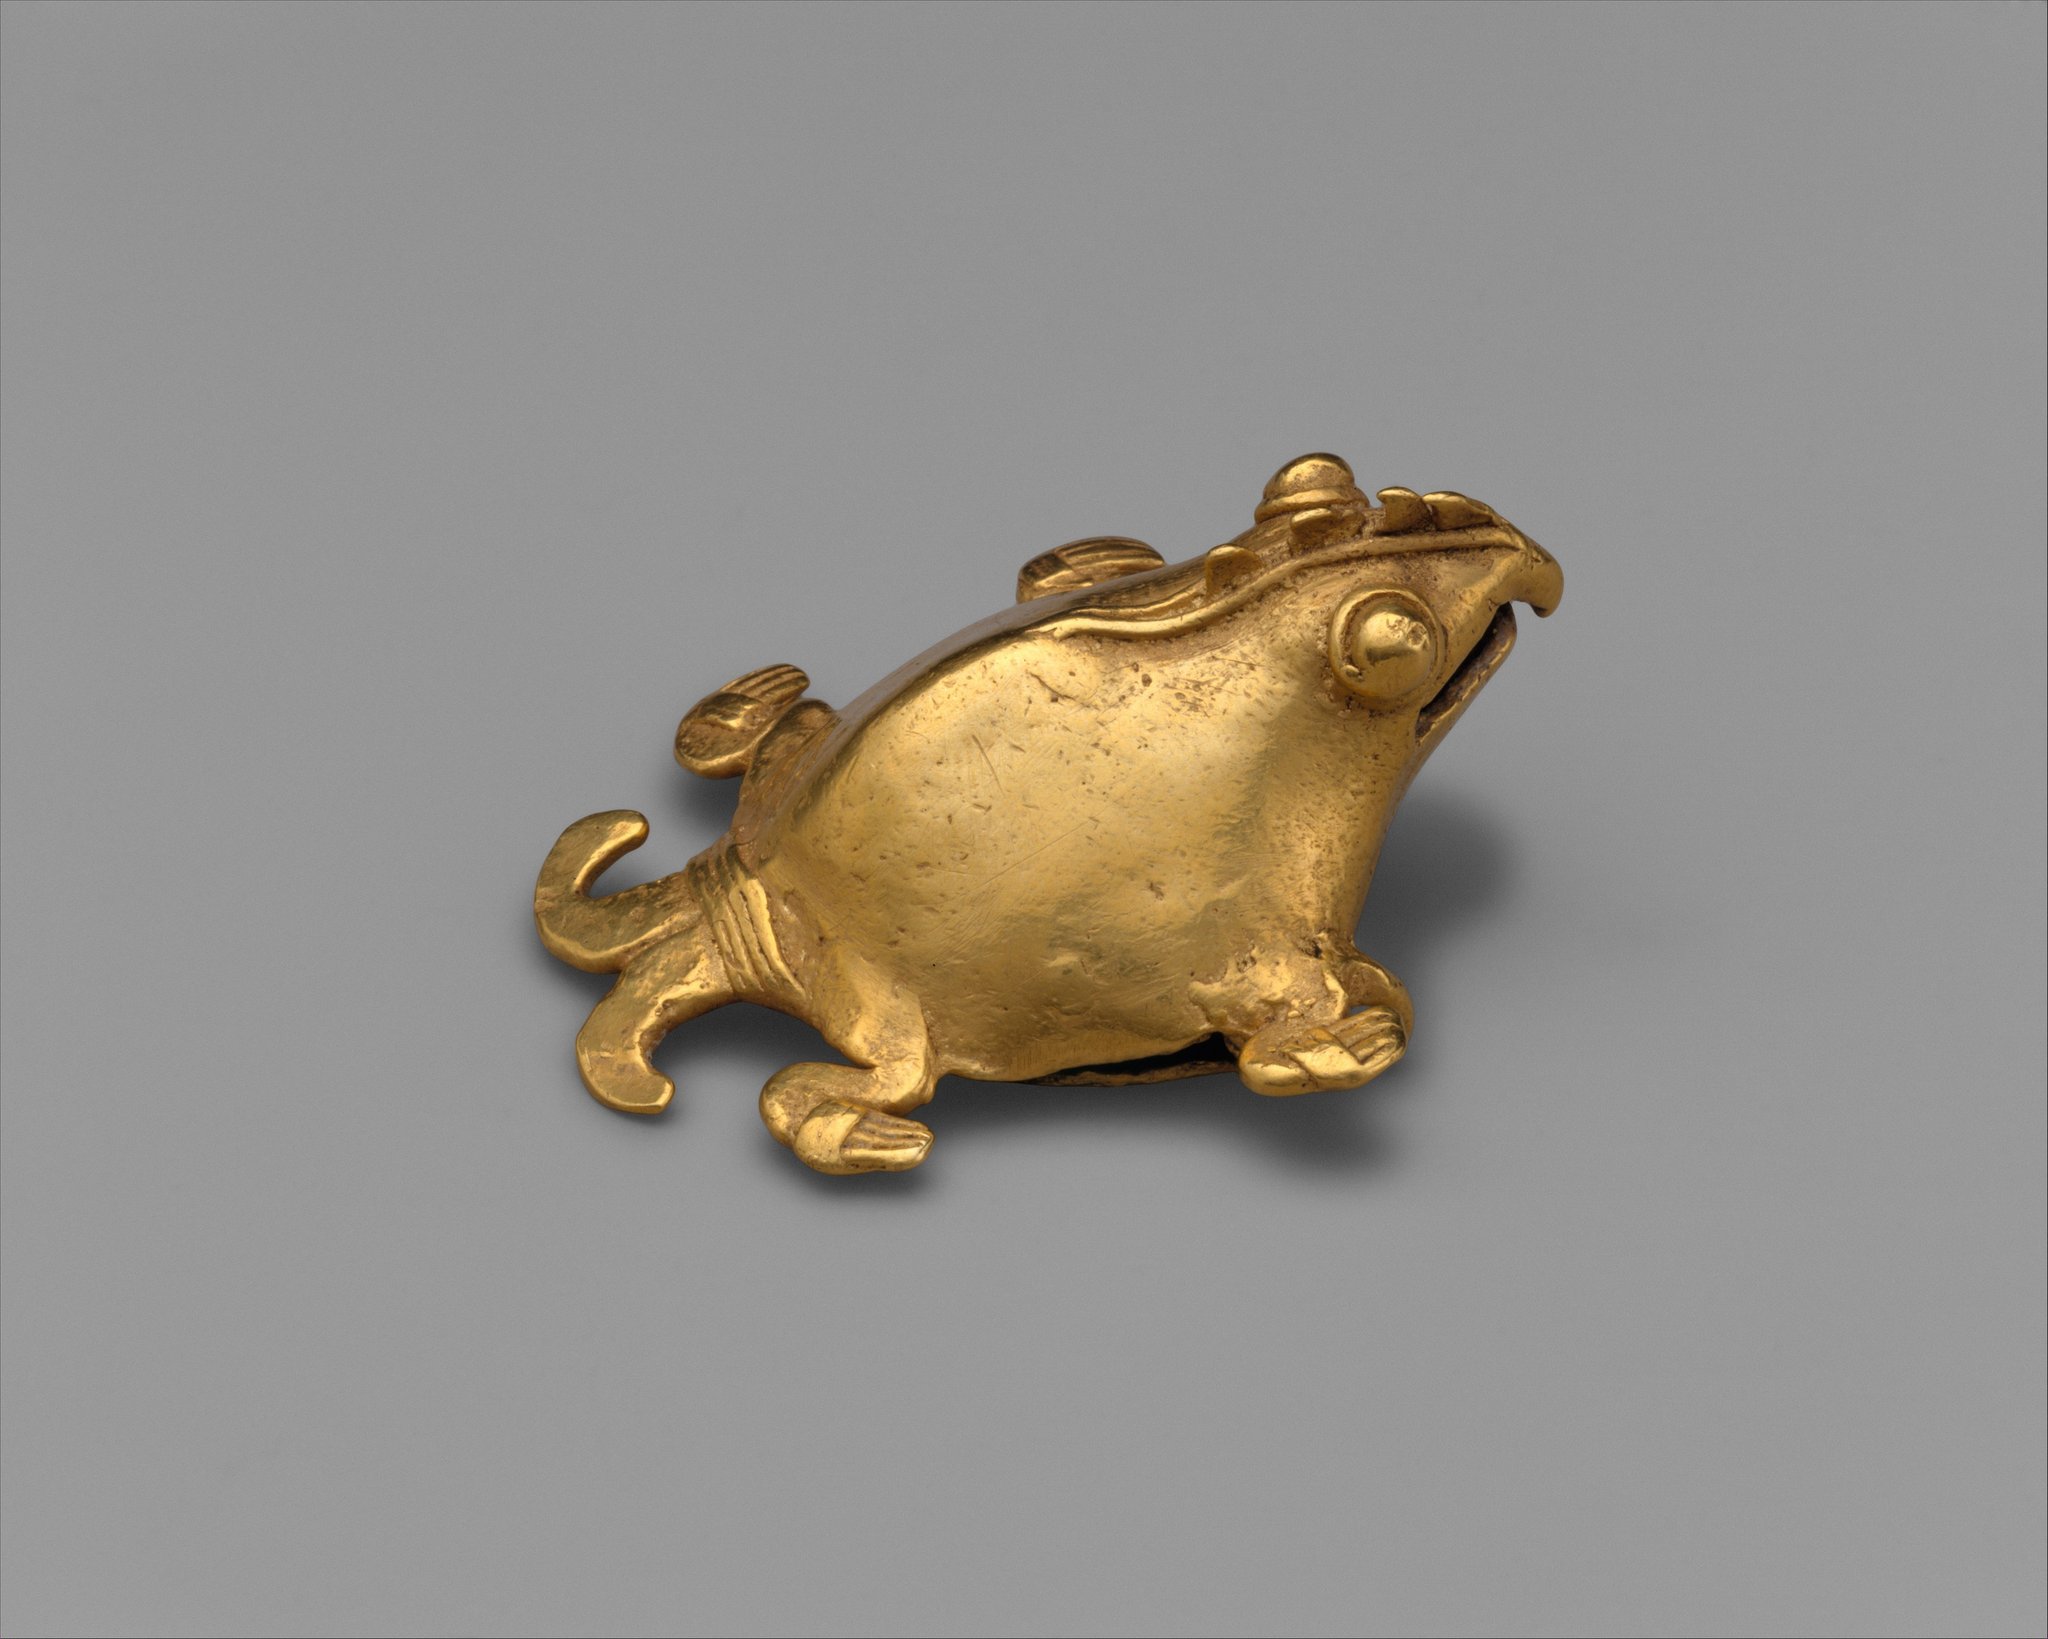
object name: pendant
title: Turtle Pendant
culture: veraguas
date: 1001-1600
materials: gold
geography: panama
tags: turtles